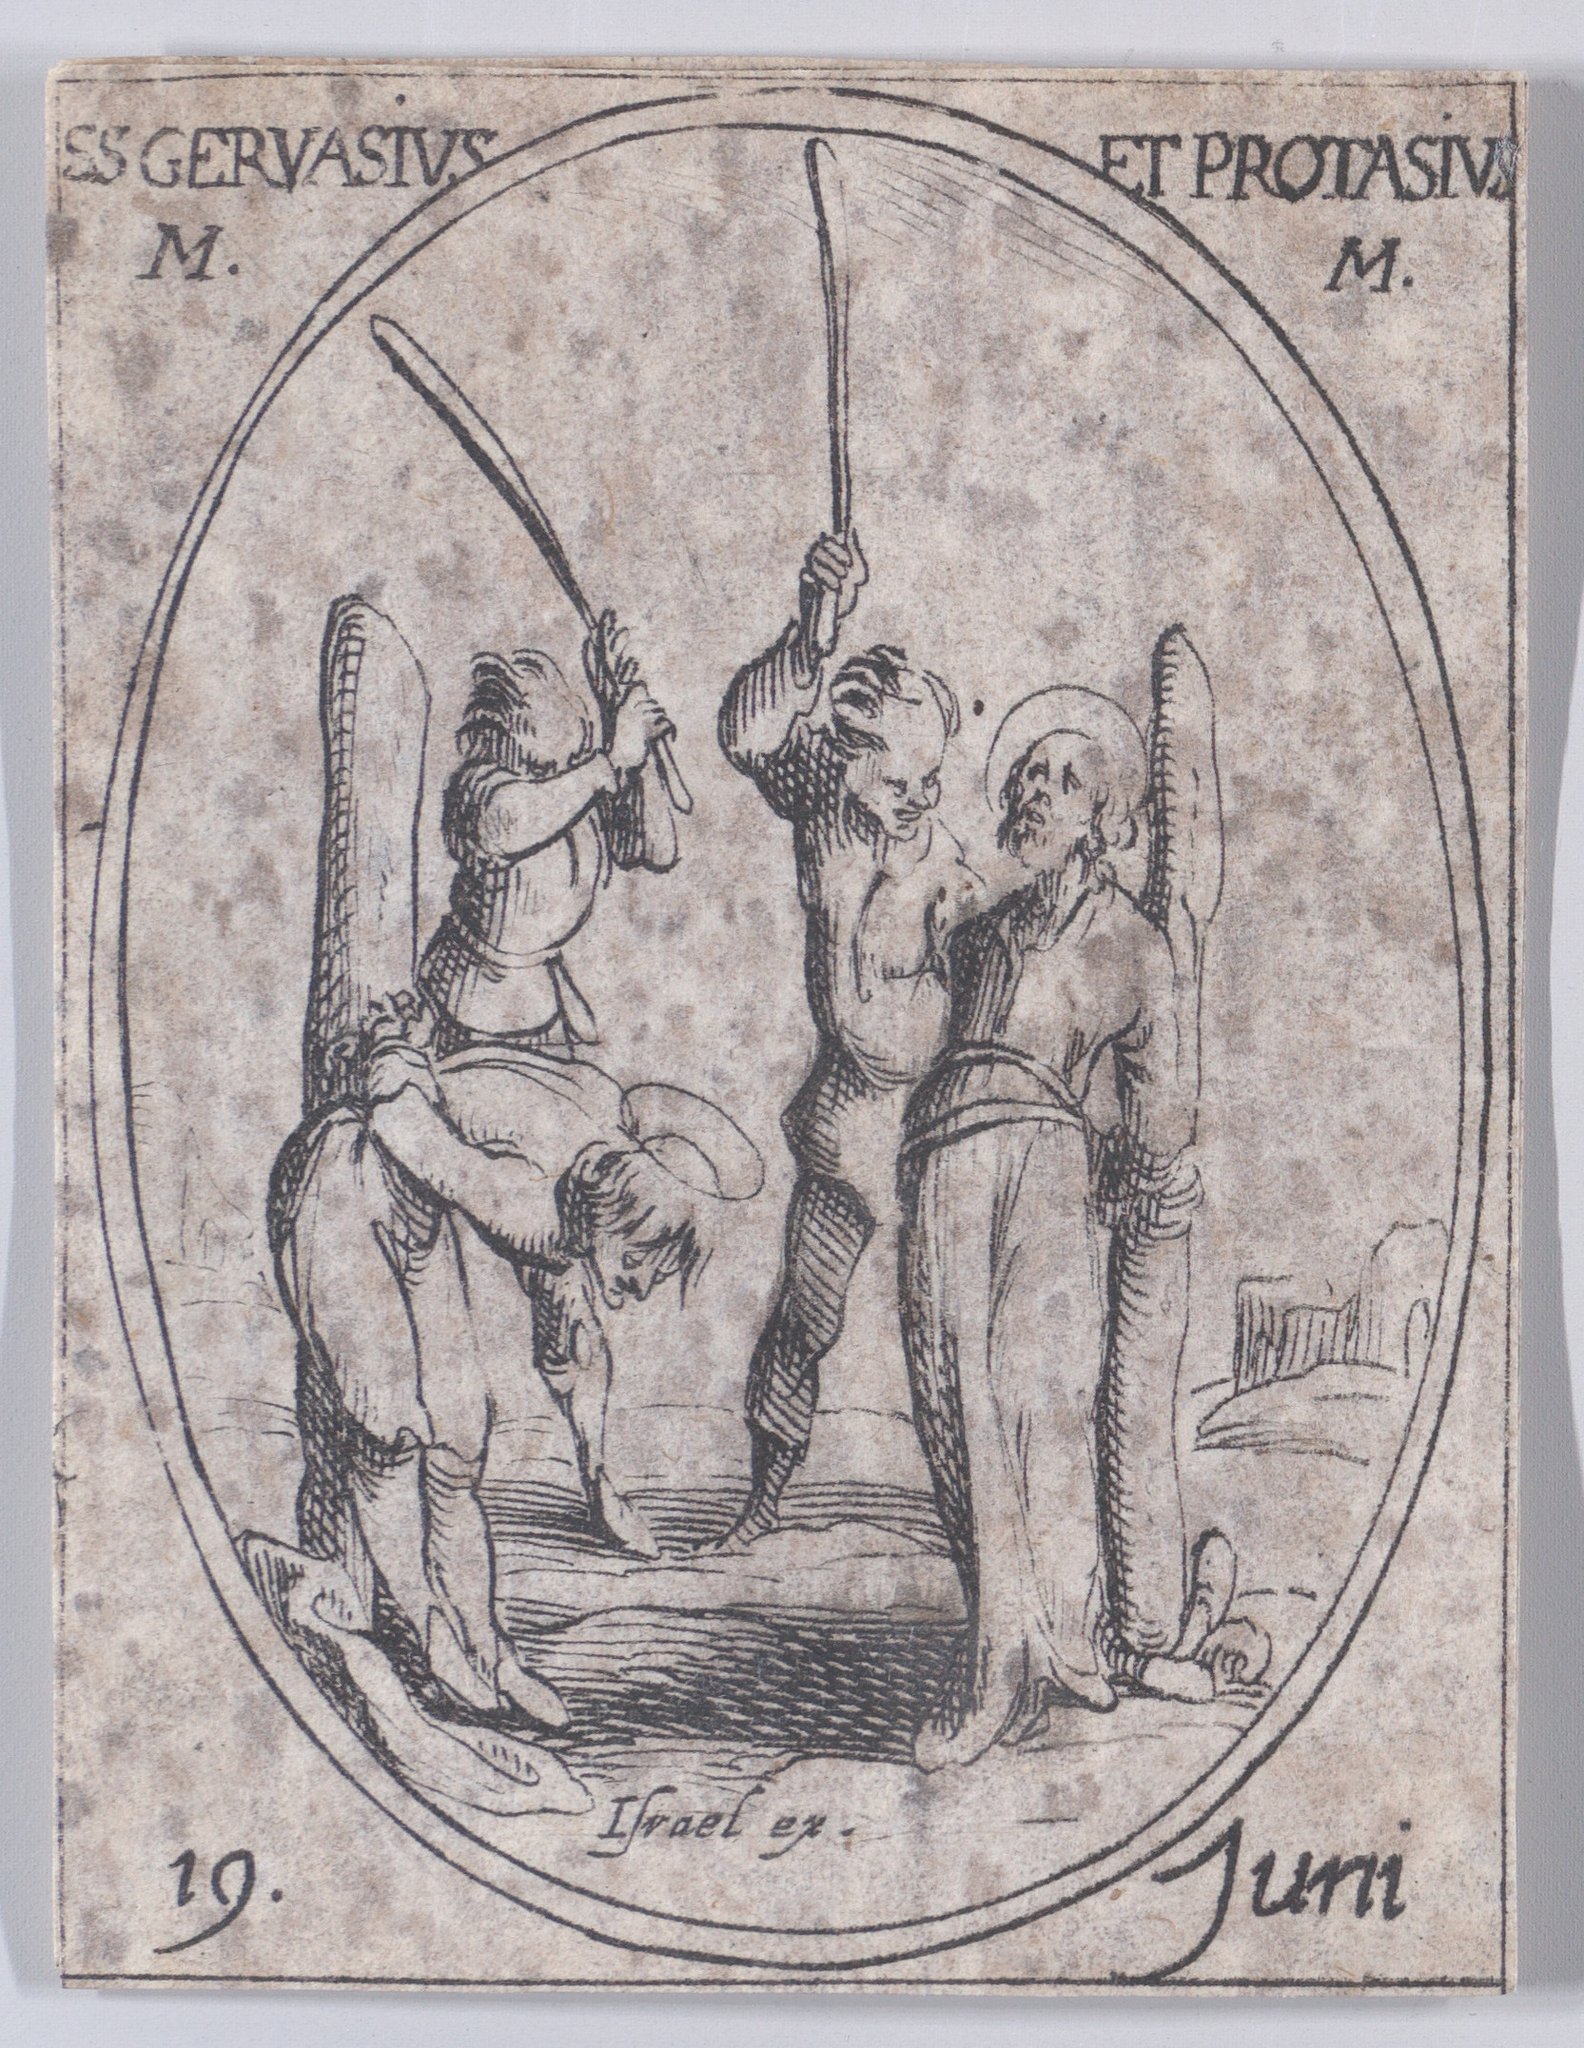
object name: print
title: S. Gervais et S. Protais, martyrs (St. Gervase and Protase, Martyrs), from "Les Images De Tous Les Saincts et Saintes de L'Année" (Images of All of the Saints and Religious Events of the Year)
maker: jacques callot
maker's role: artist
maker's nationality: french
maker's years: 1592-1635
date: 1636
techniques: etching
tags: men,saints